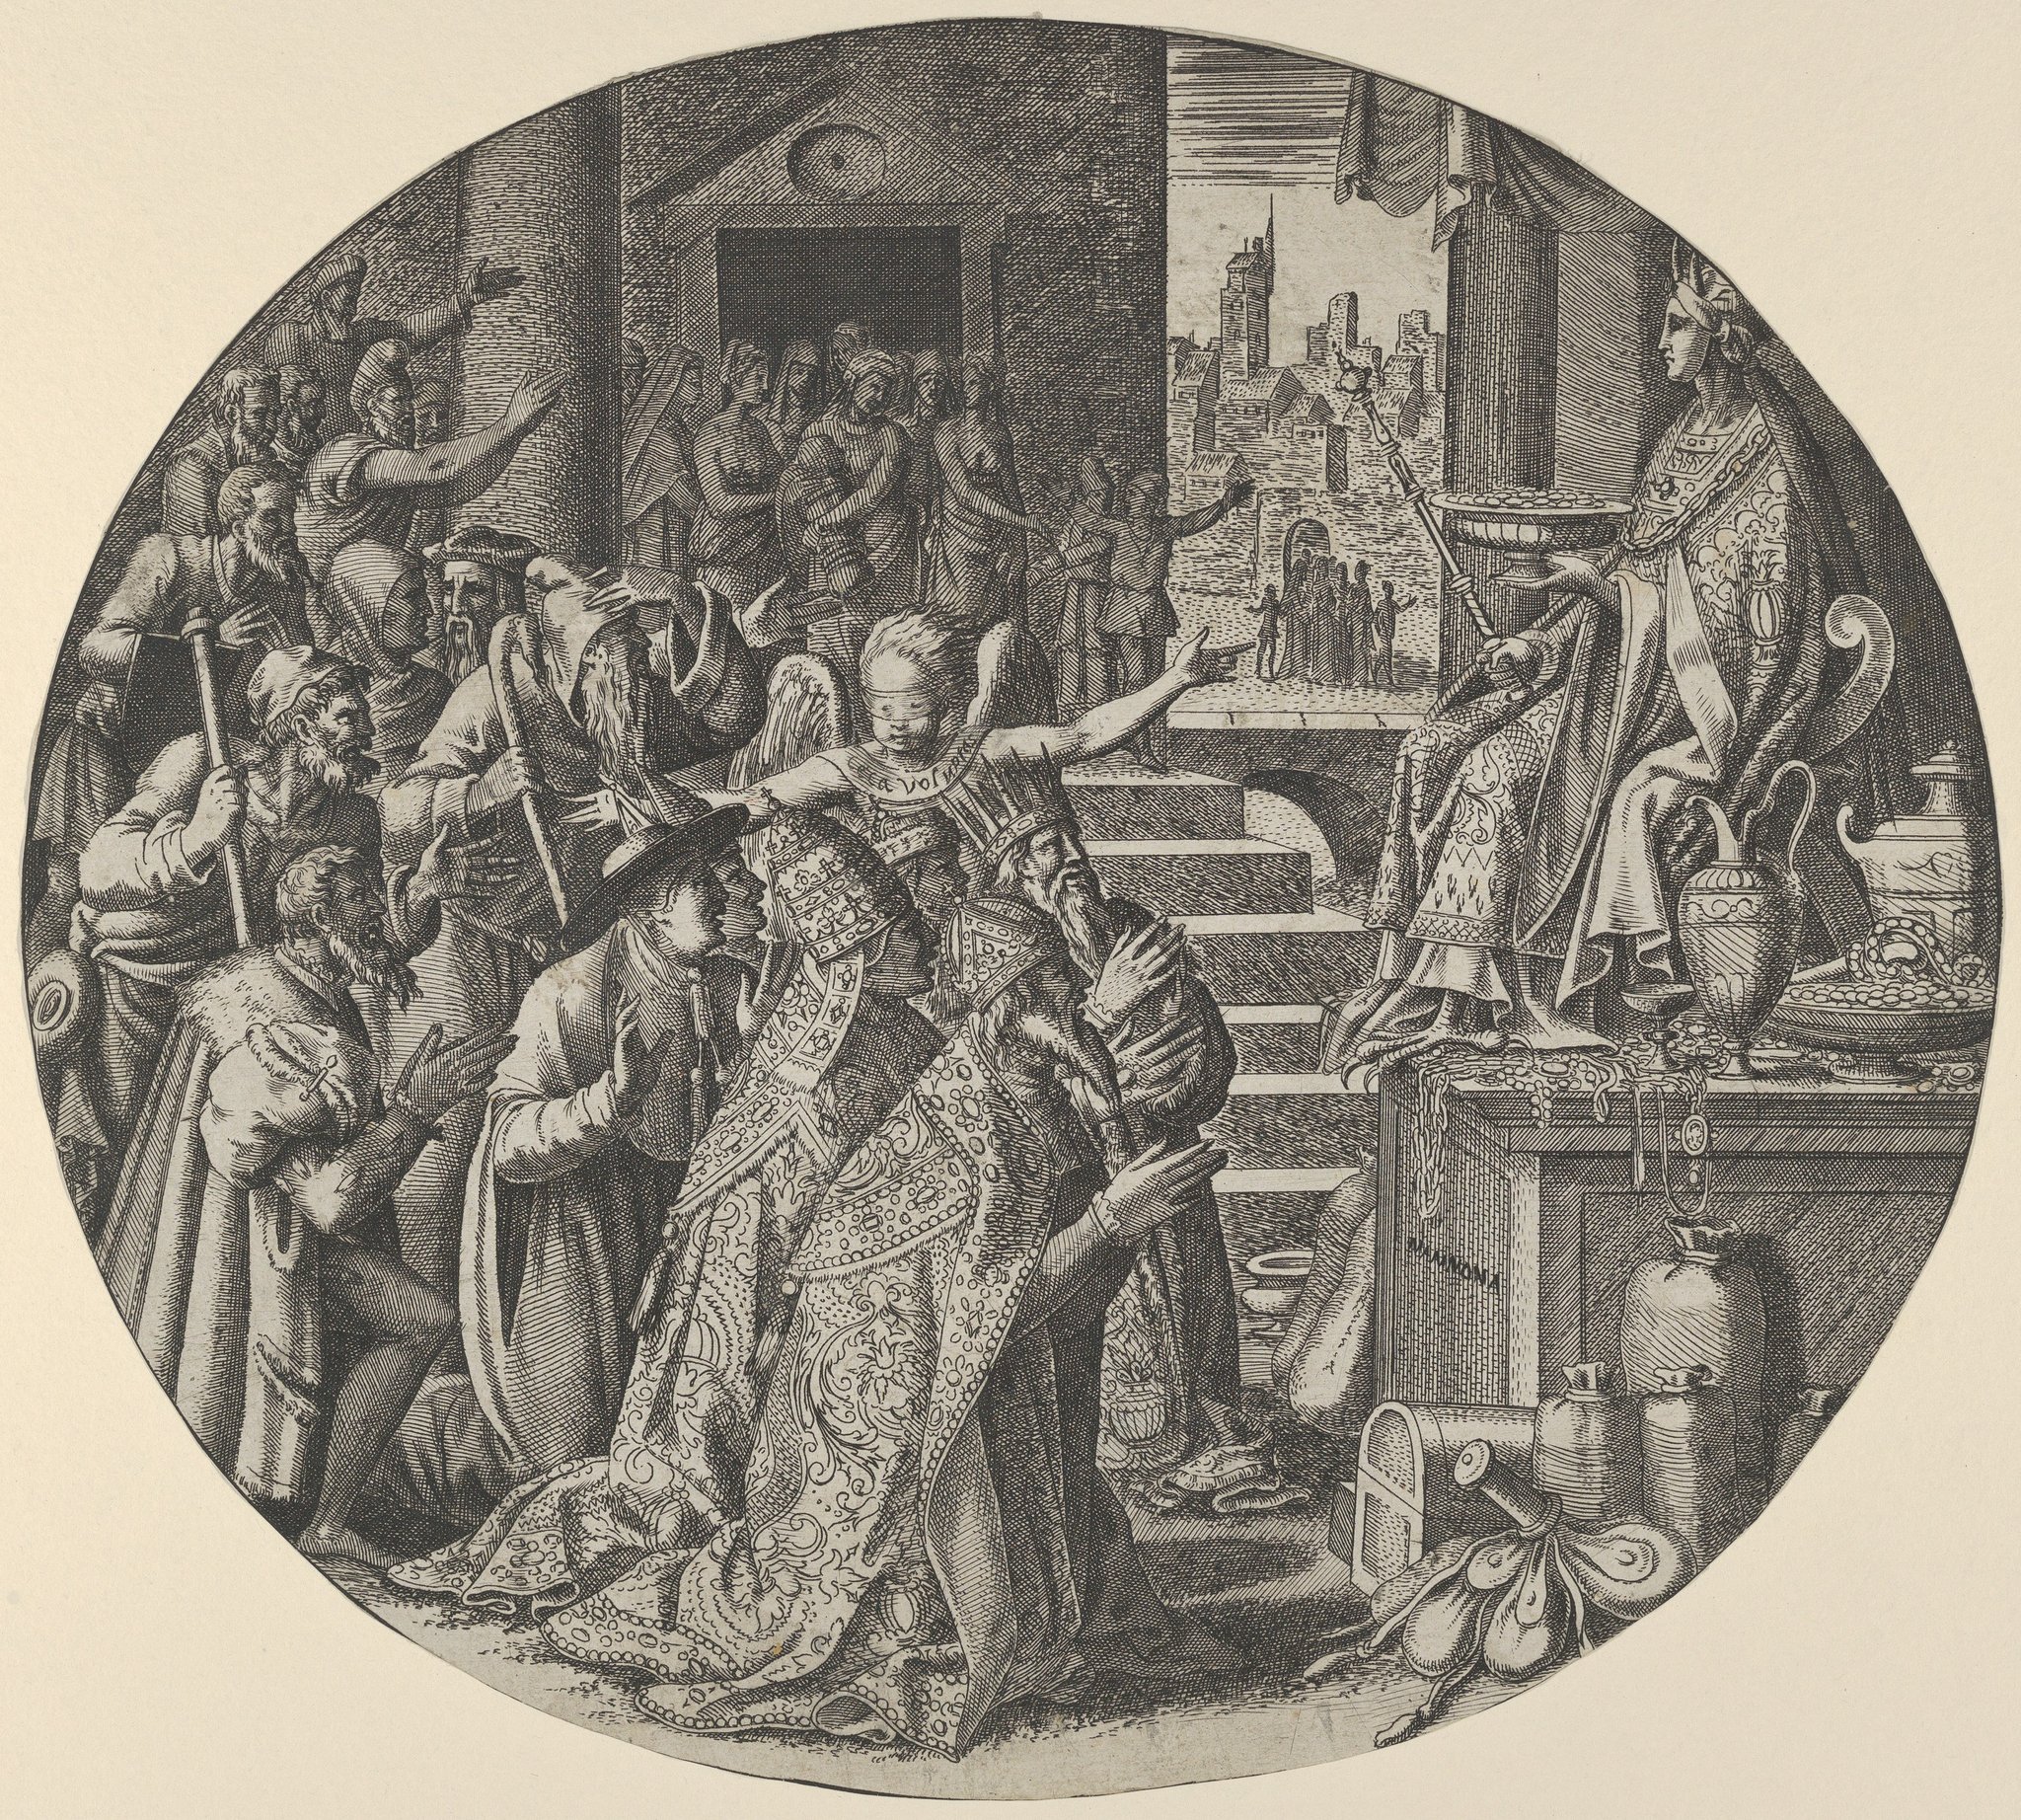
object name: print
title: Avarice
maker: léon davent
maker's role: artist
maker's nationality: french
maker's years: 1540-1556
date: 1550-1555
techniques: etching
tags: soldiers,kings,crowd